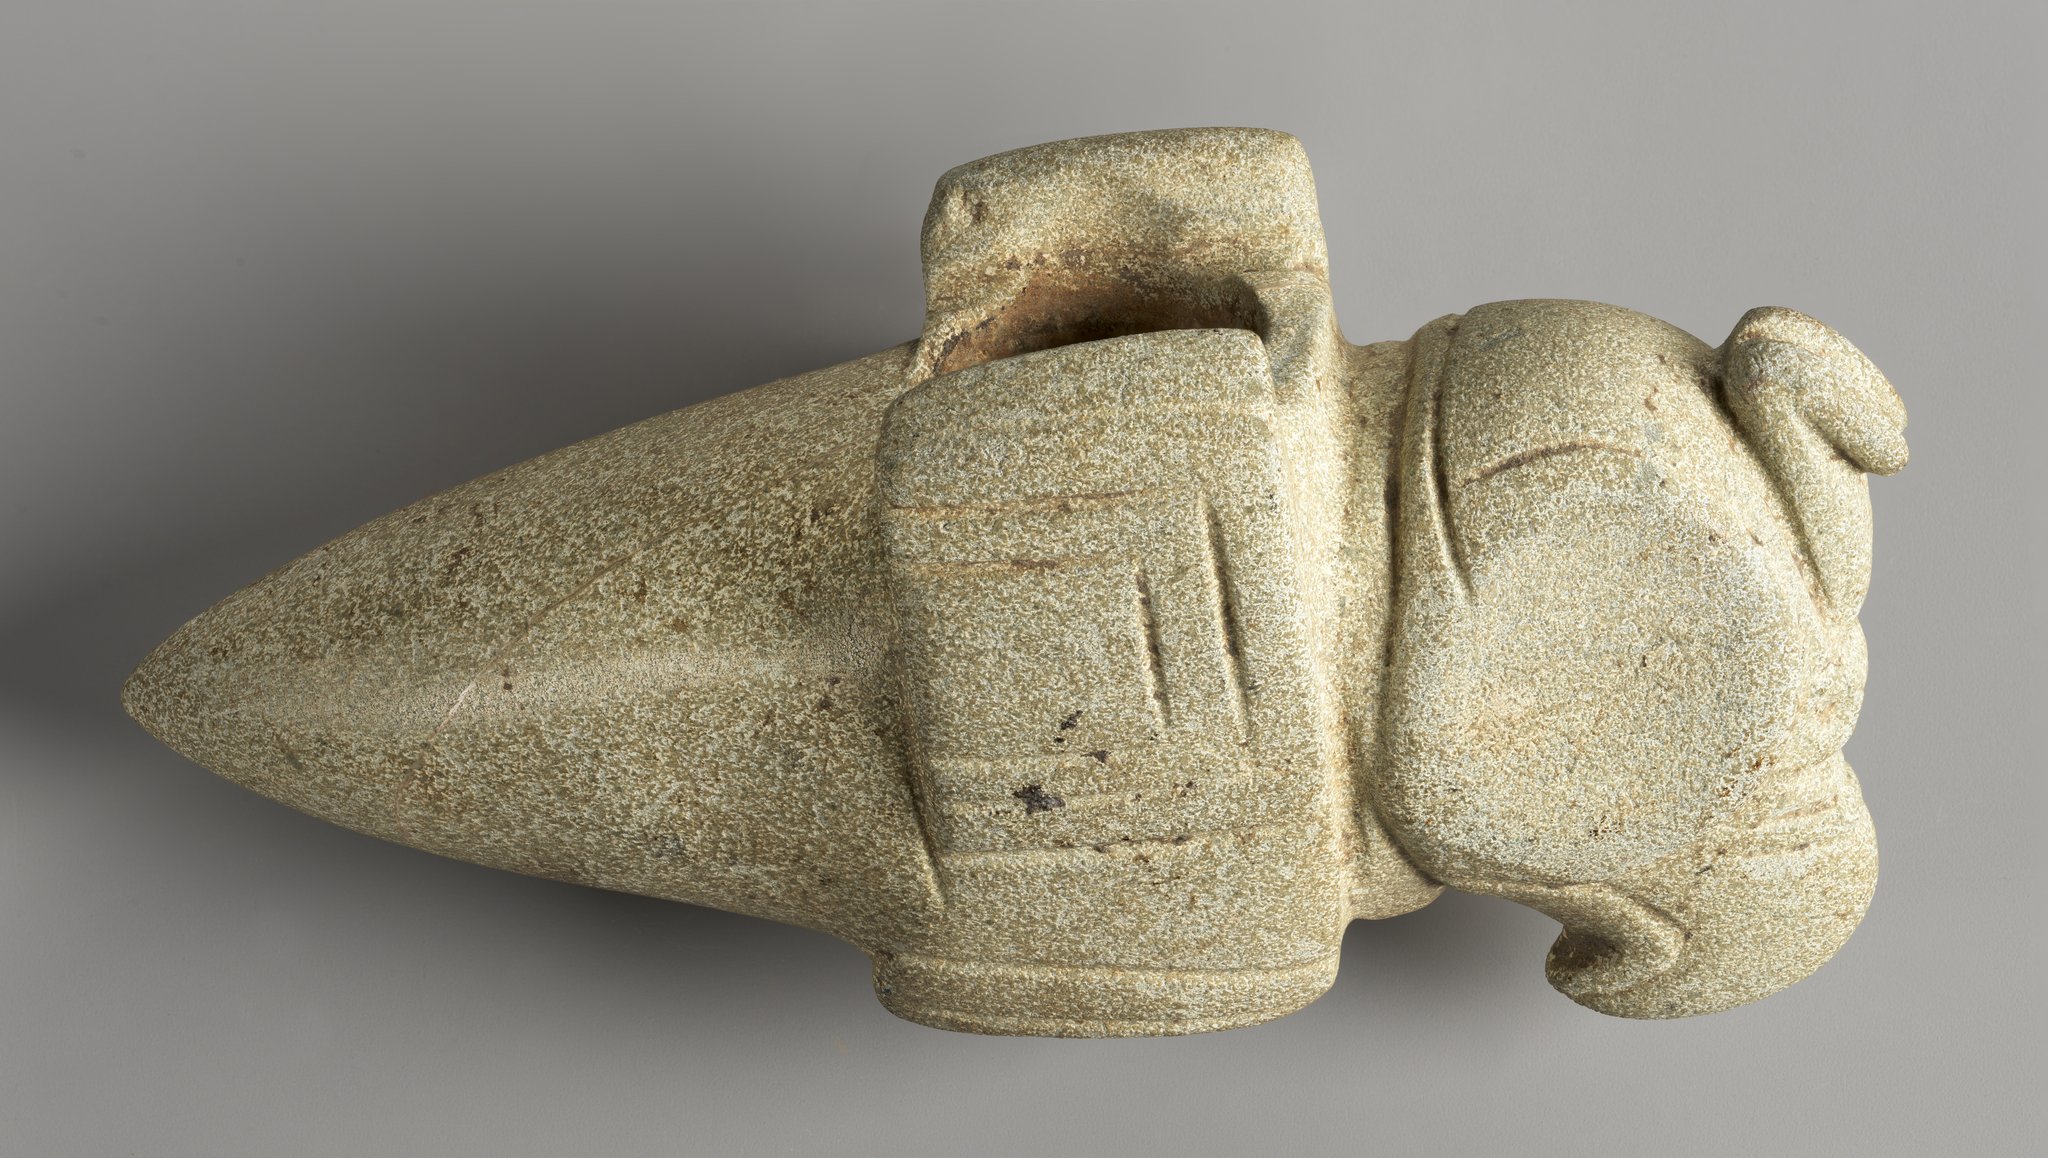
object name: mace head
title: Mace Head, Bird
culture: atlantic watershed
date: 401-1200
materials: stone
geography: costa rica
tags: birds